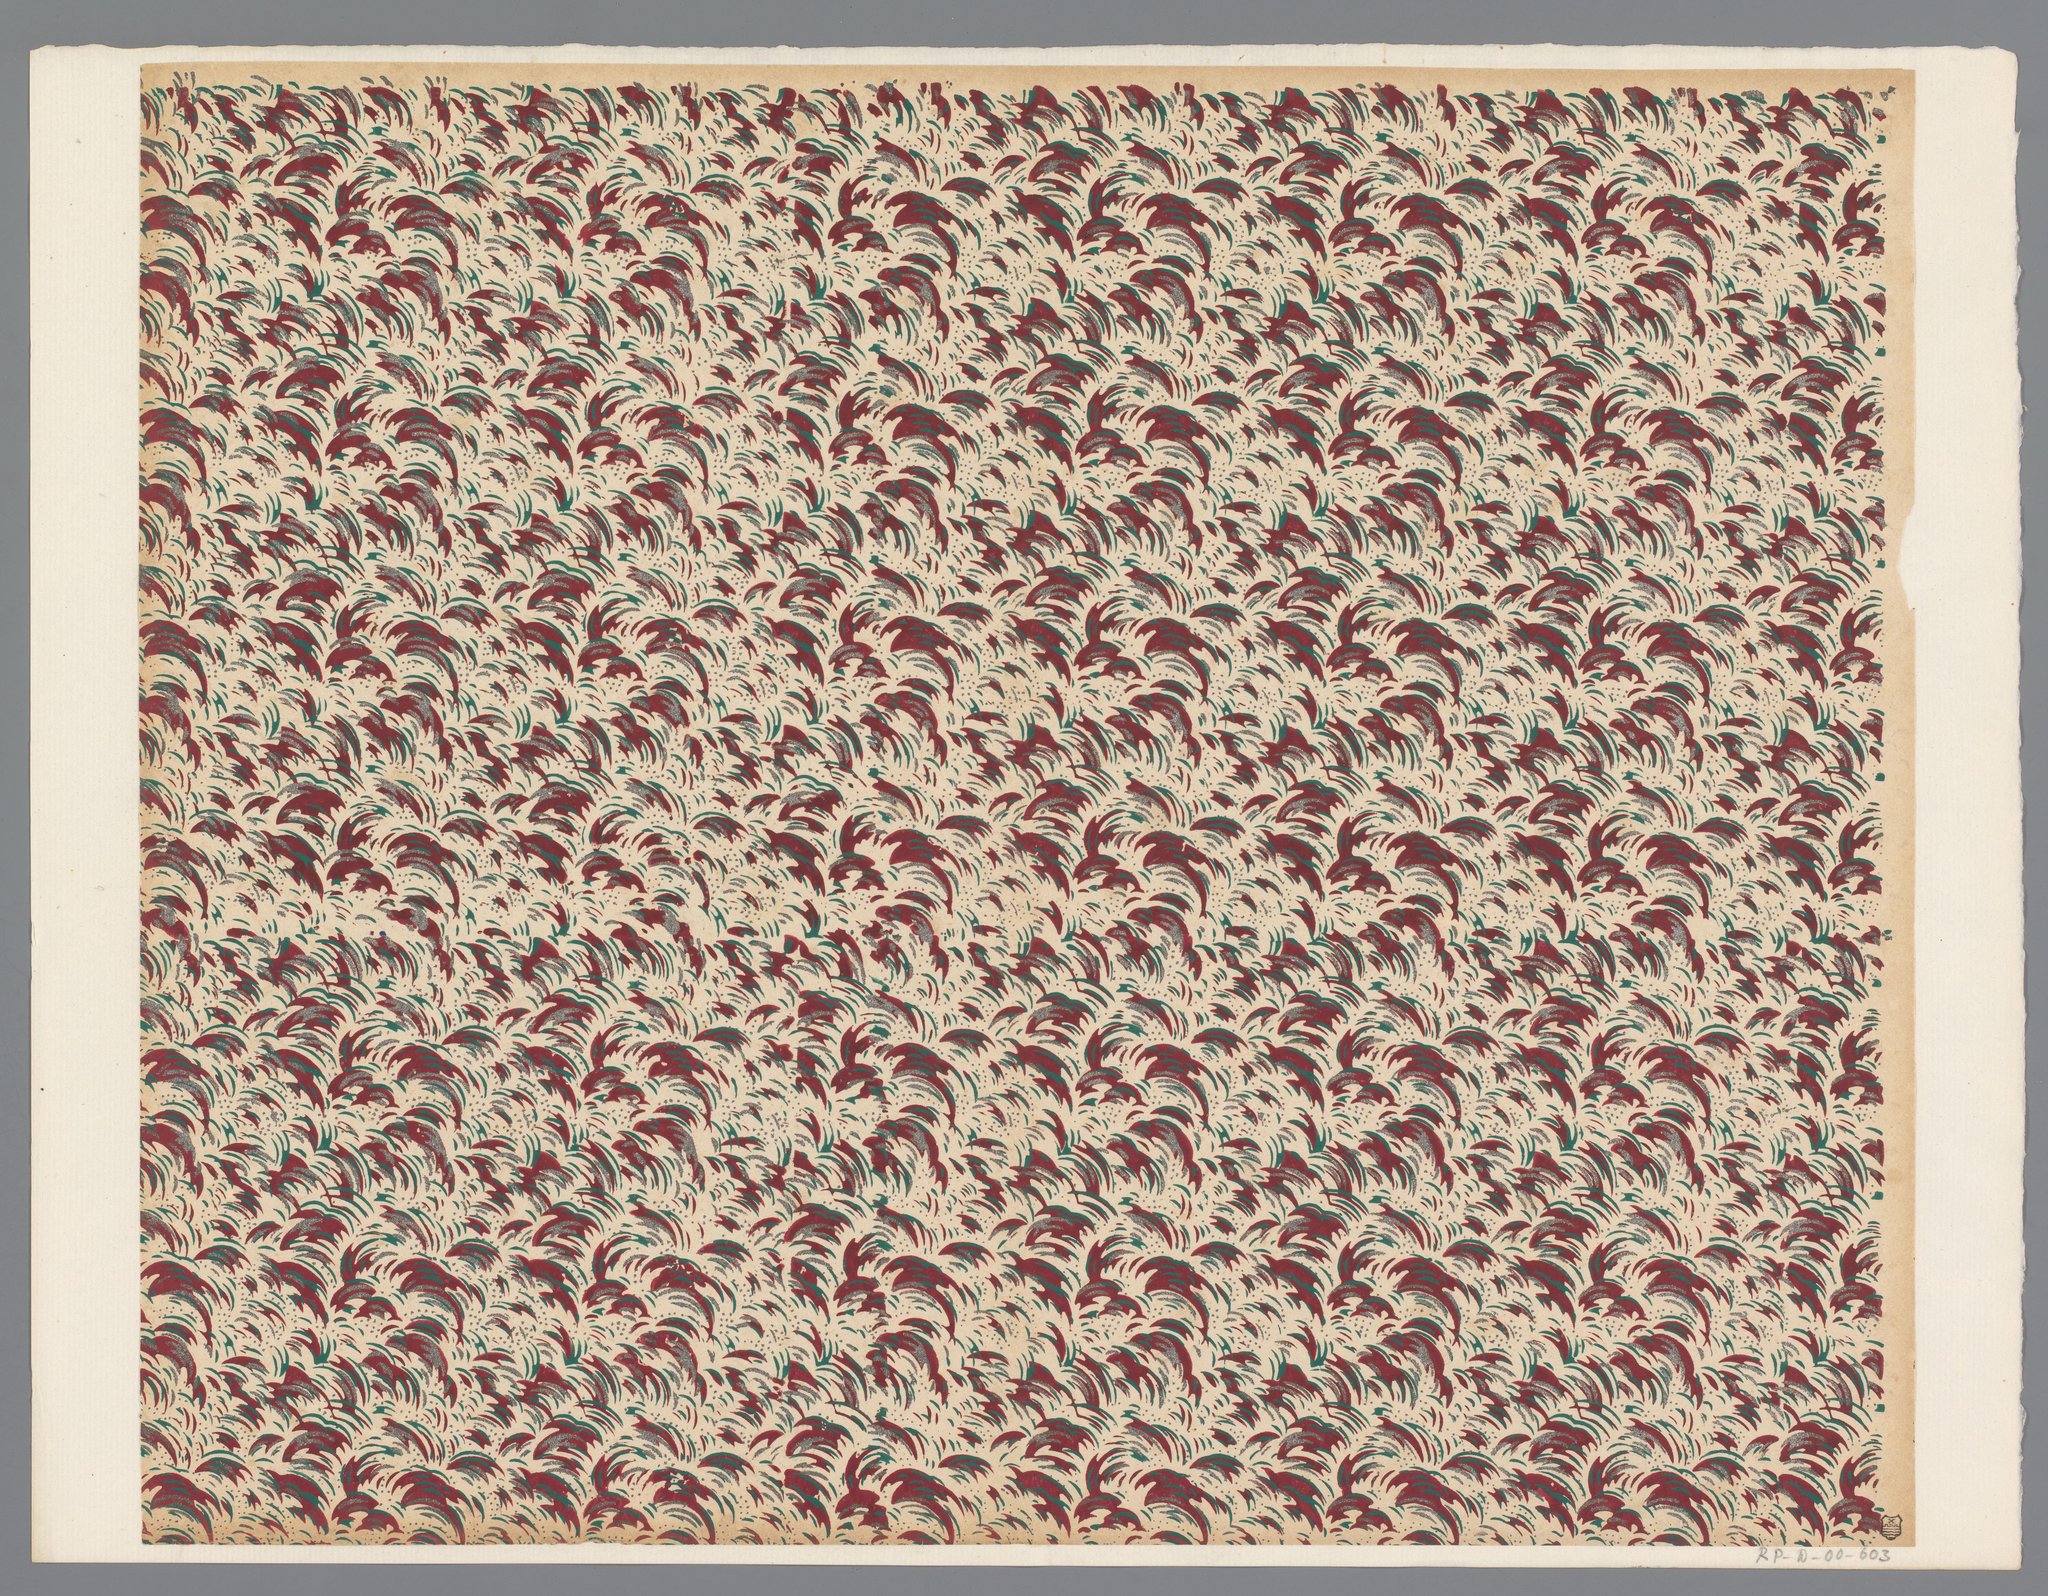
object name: printed paper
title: Blad met strooipatroon van bladmotief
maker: Anonymous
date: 1800-1900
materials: paper, paint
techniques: printing block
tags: ornament derived from plant forms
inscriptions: collector's mark: Lugt 2760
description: Blad met strooipatroon van blad- of schulpmotief.